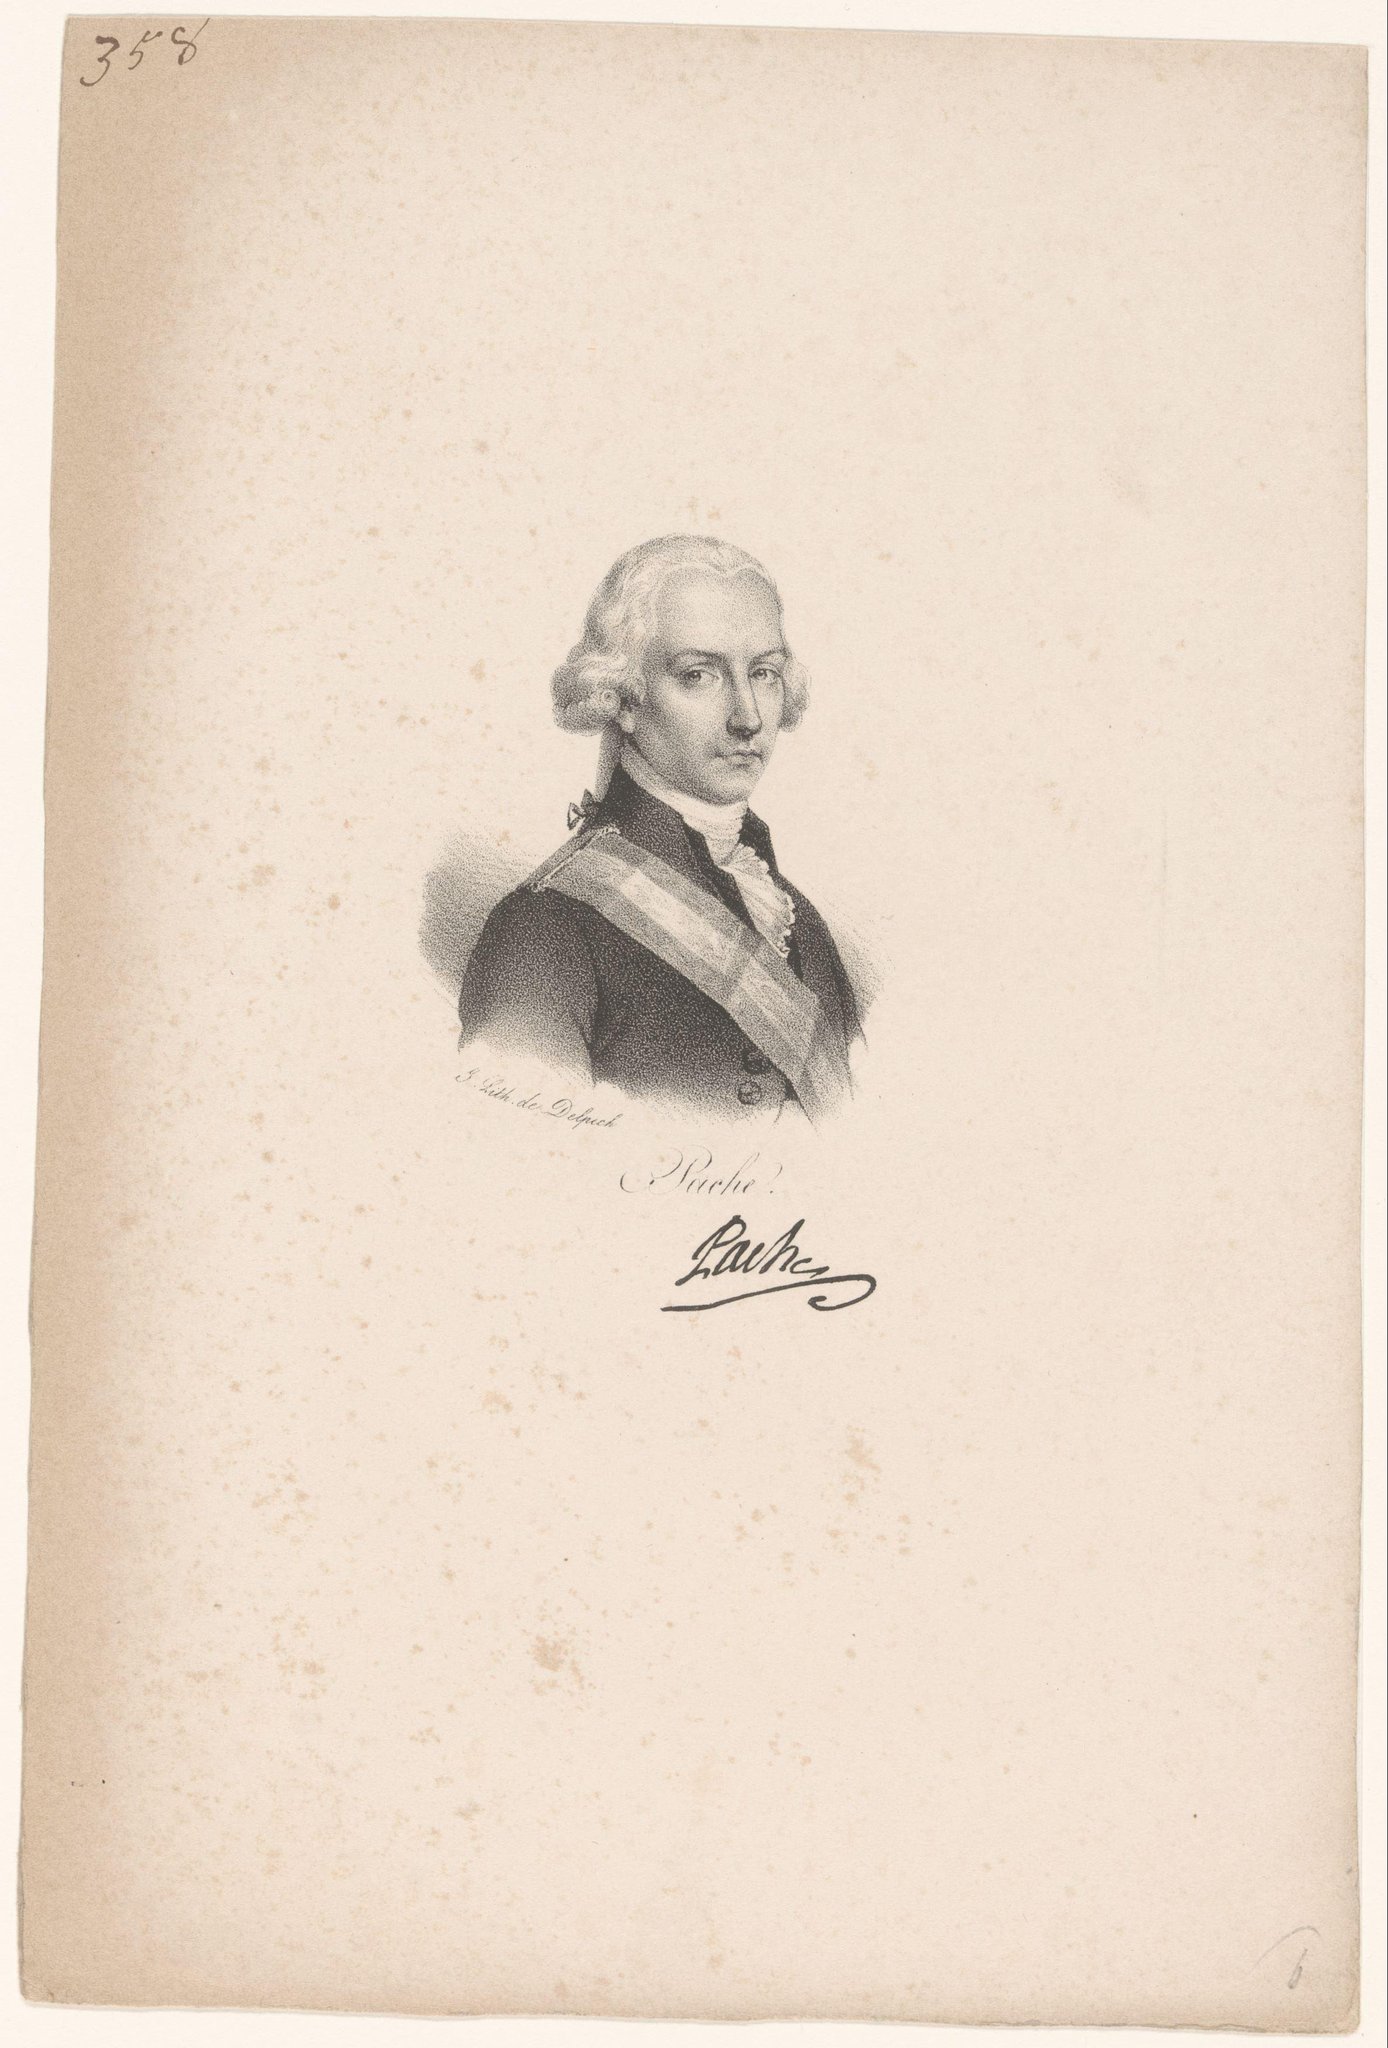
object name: print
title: Portret van Jean-Nicolas Pache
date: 1829-1842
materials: paper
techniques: lithograph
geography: paris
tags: politician, mayor, historical persons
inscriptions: collector's mark: Lugt 2228a